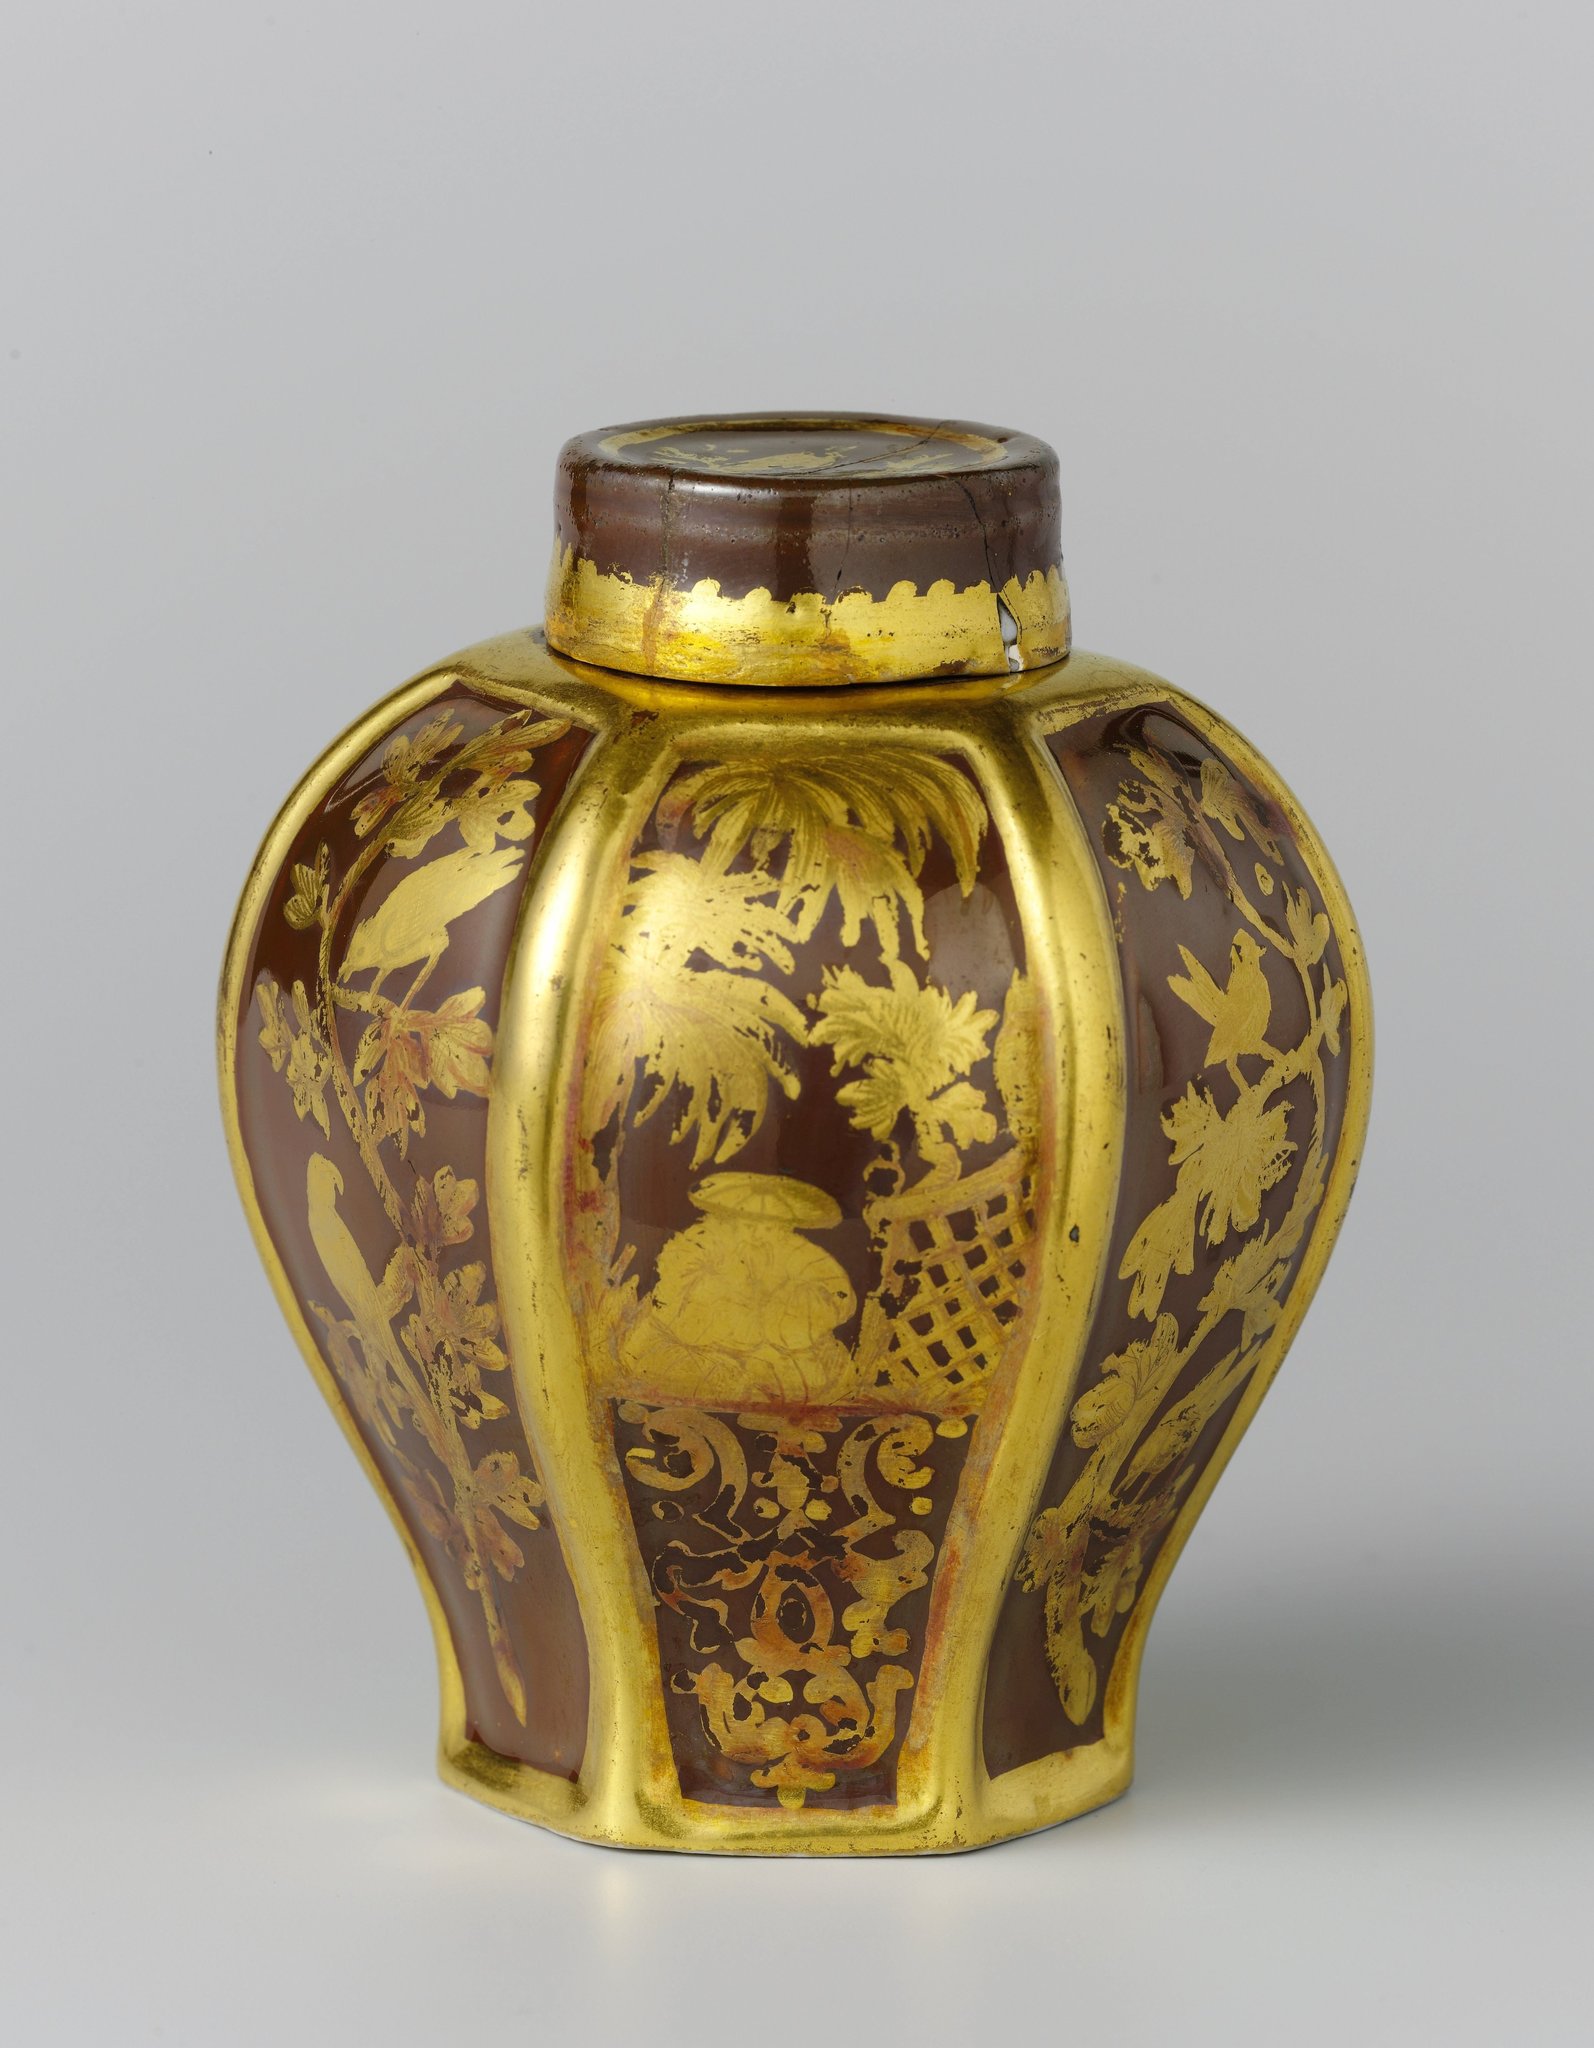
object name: tea caddy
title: Lidded tea caddy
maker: Anonymous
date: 1730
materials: porcelain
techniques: painted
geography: meissen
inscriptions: number: ‘68.’, factory mark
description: Meissener Porzellan Manufaktur Meissen, c. 1730 painted decoration: Augsburg, c. 1735 hard-paste porcelain